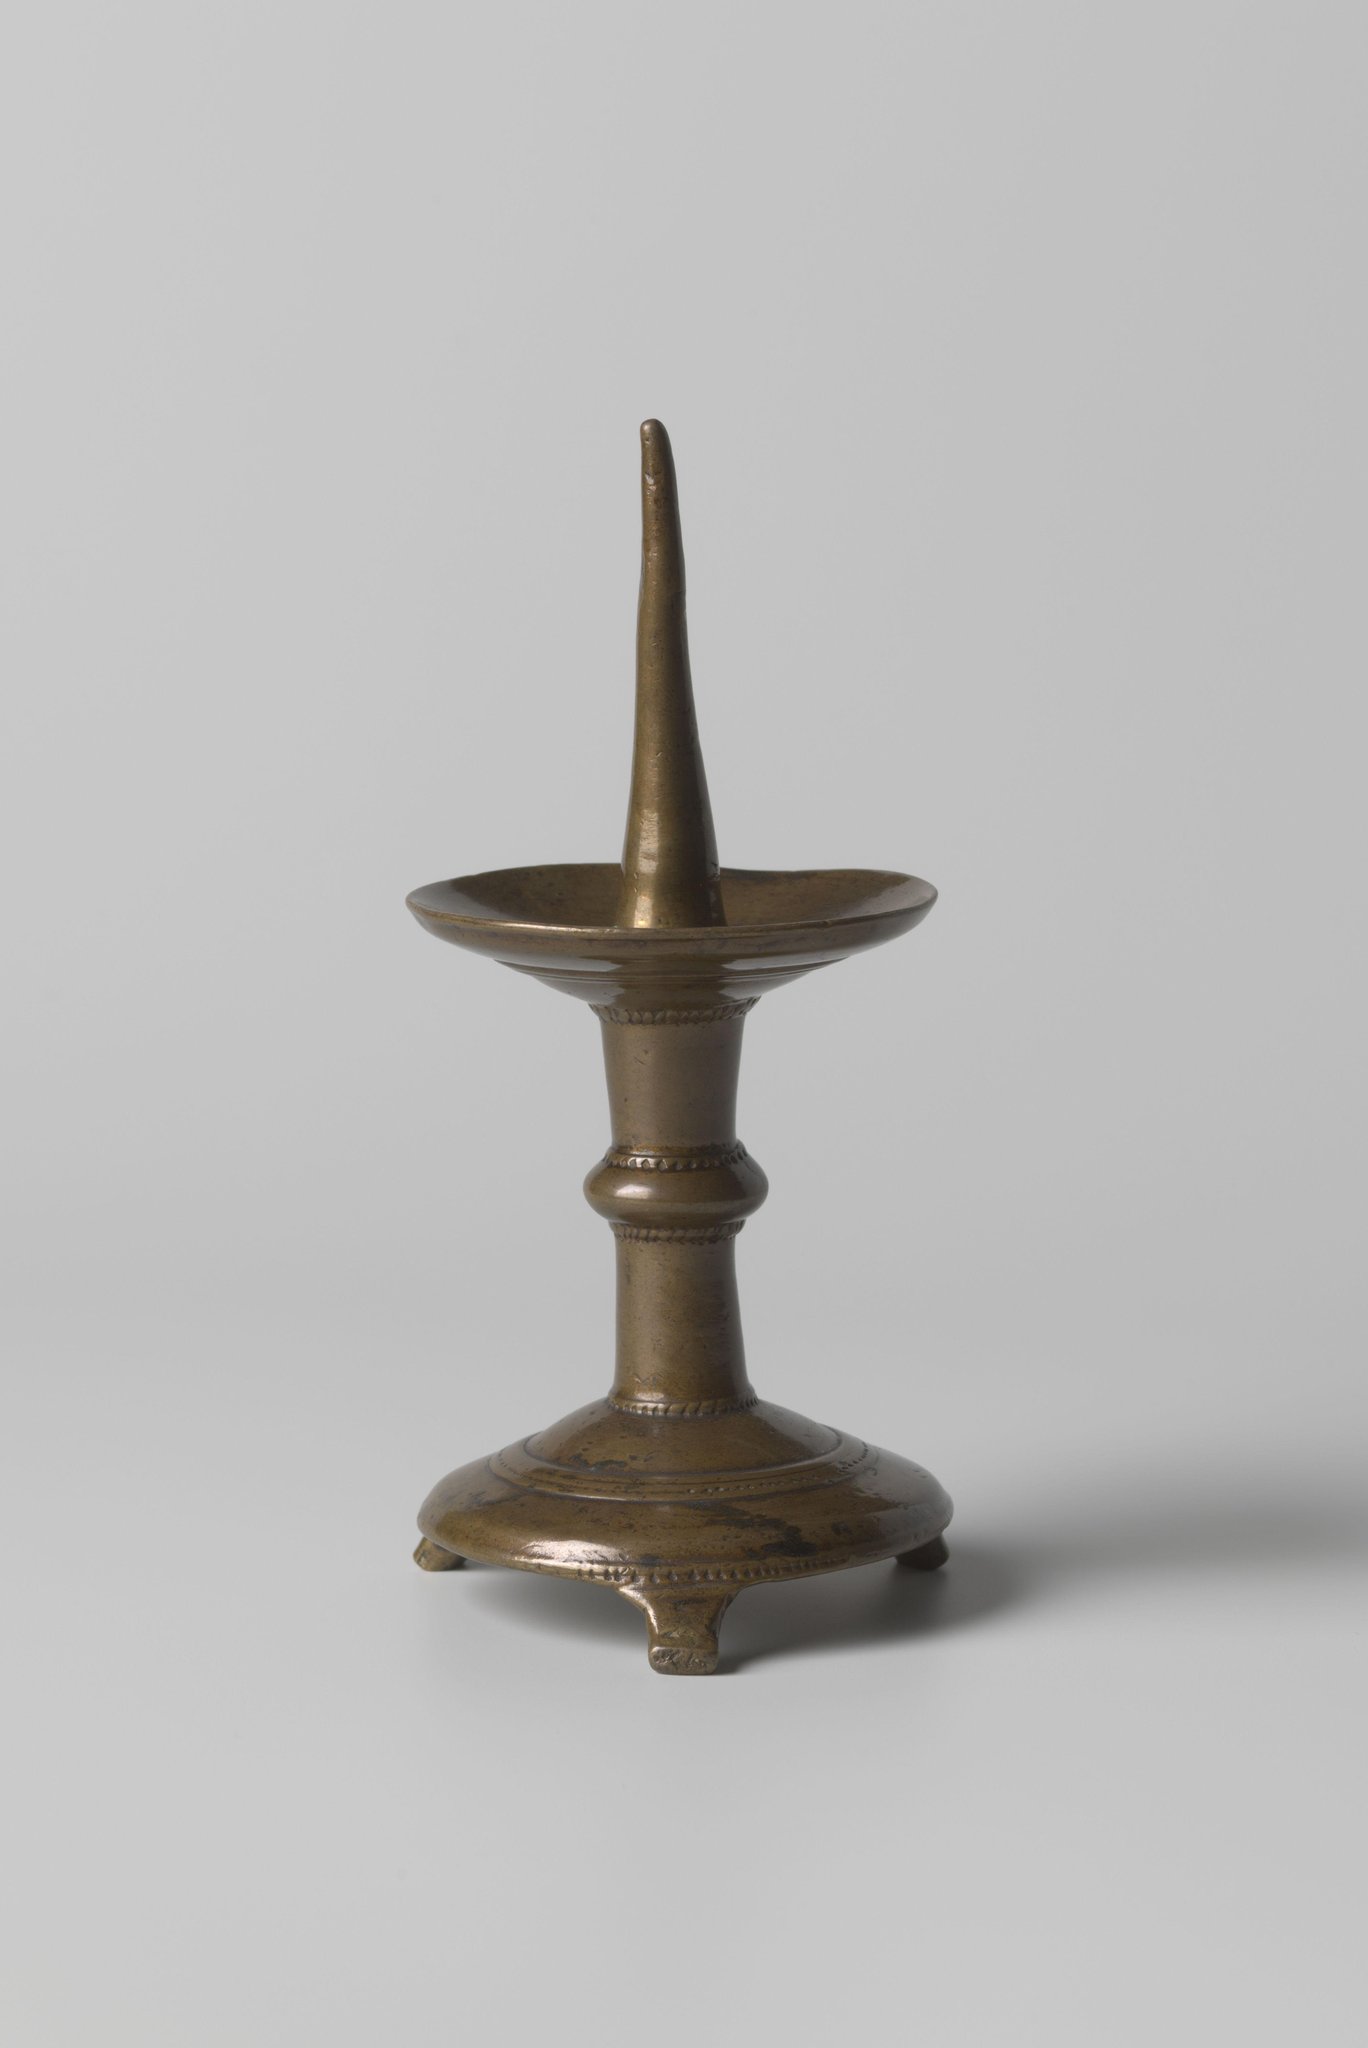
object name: candlestick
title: Kandelaar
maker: Anonymous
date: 1200-1300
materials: copper alloy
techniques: casting, striking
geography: northern netherlands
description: Candlestick. Bronze or brass, Netherlands, 13th century.